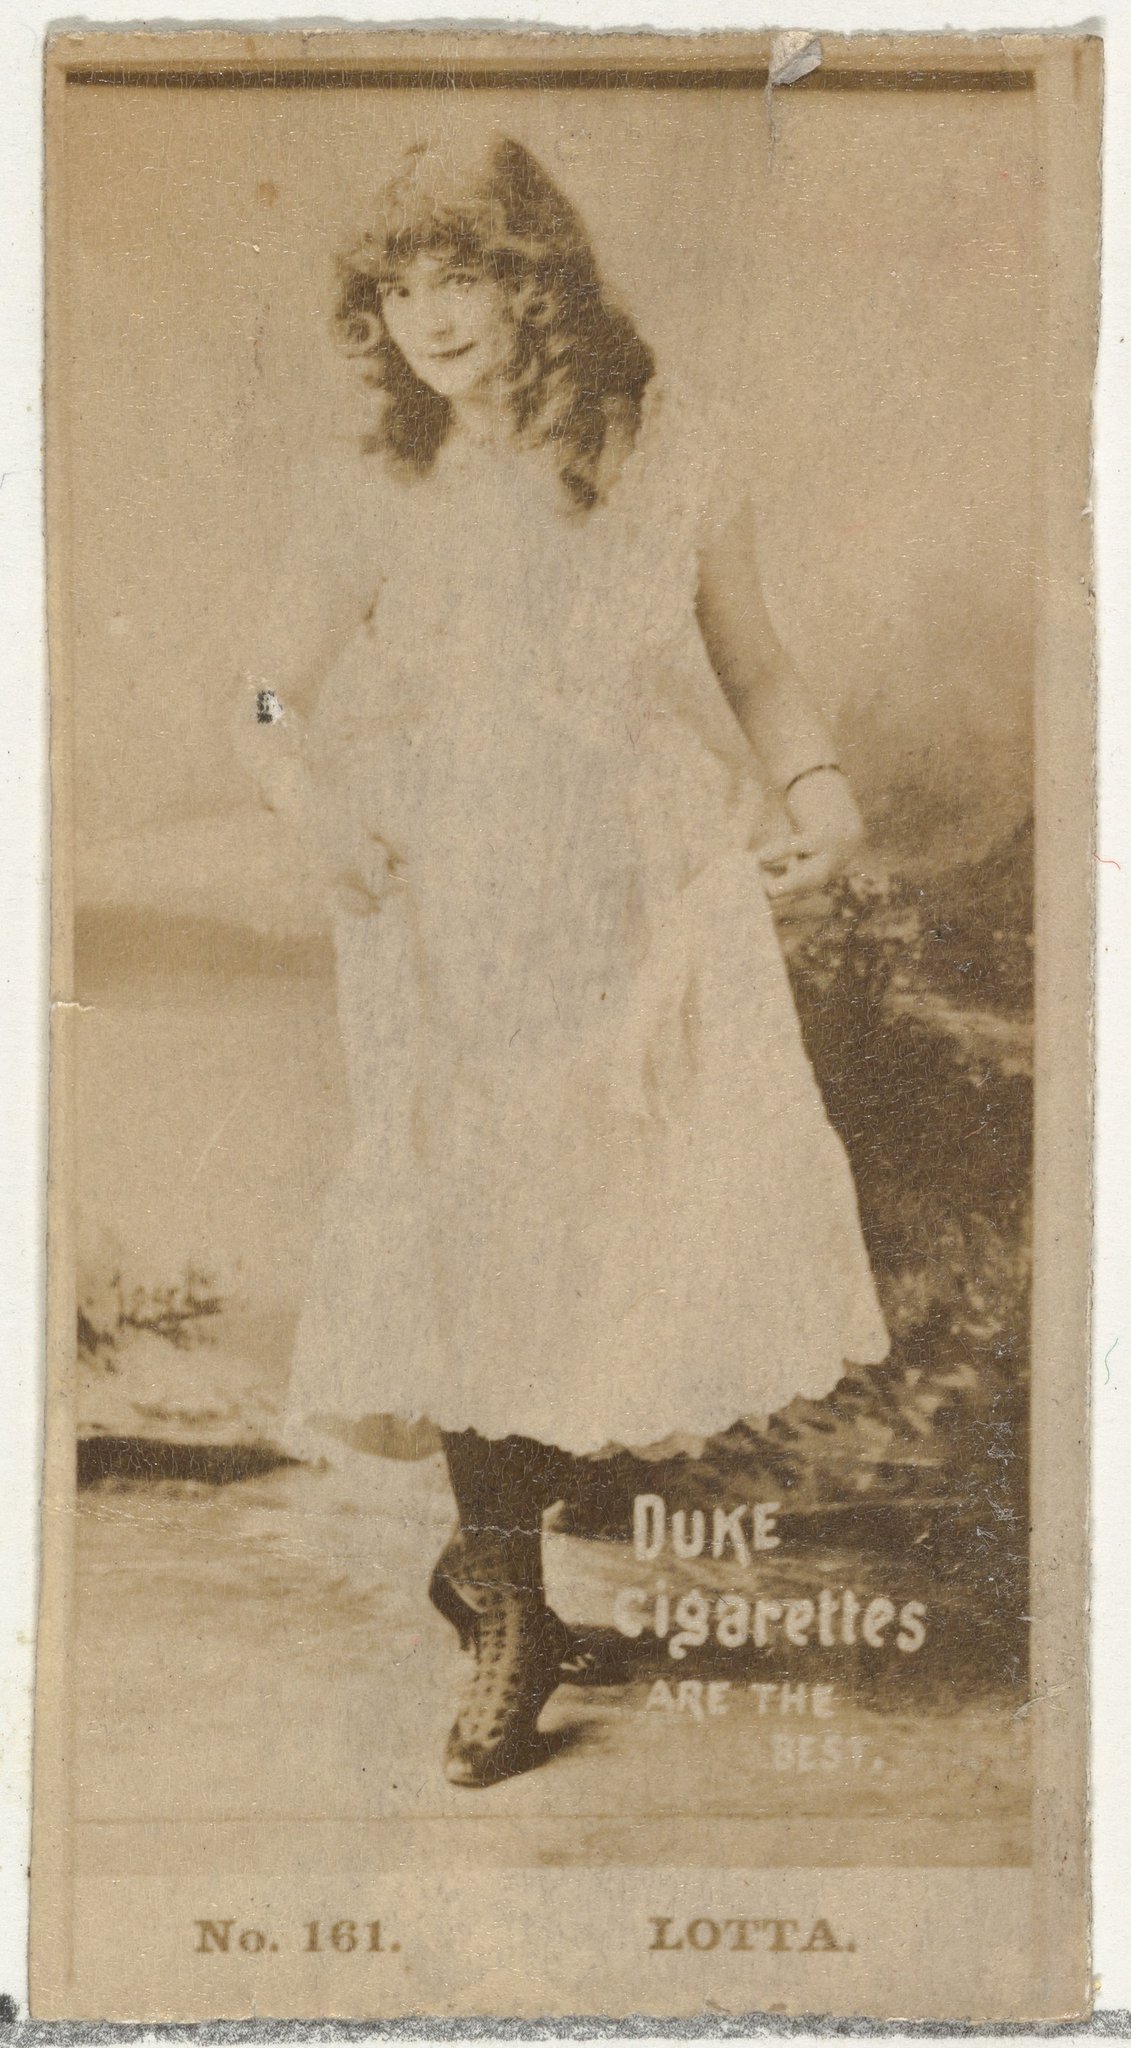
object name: photograph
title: Card Number 161, Lotta, from the Actors and Actresses series (N145-6) issued by Duke Sons & Co. to promote Duke Cigarettes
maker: w. duke, sons & co.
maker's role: publisher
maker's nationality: american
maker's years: 1870-1920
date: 1880-1889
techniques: albumen silver print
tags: portraits,women,actresses